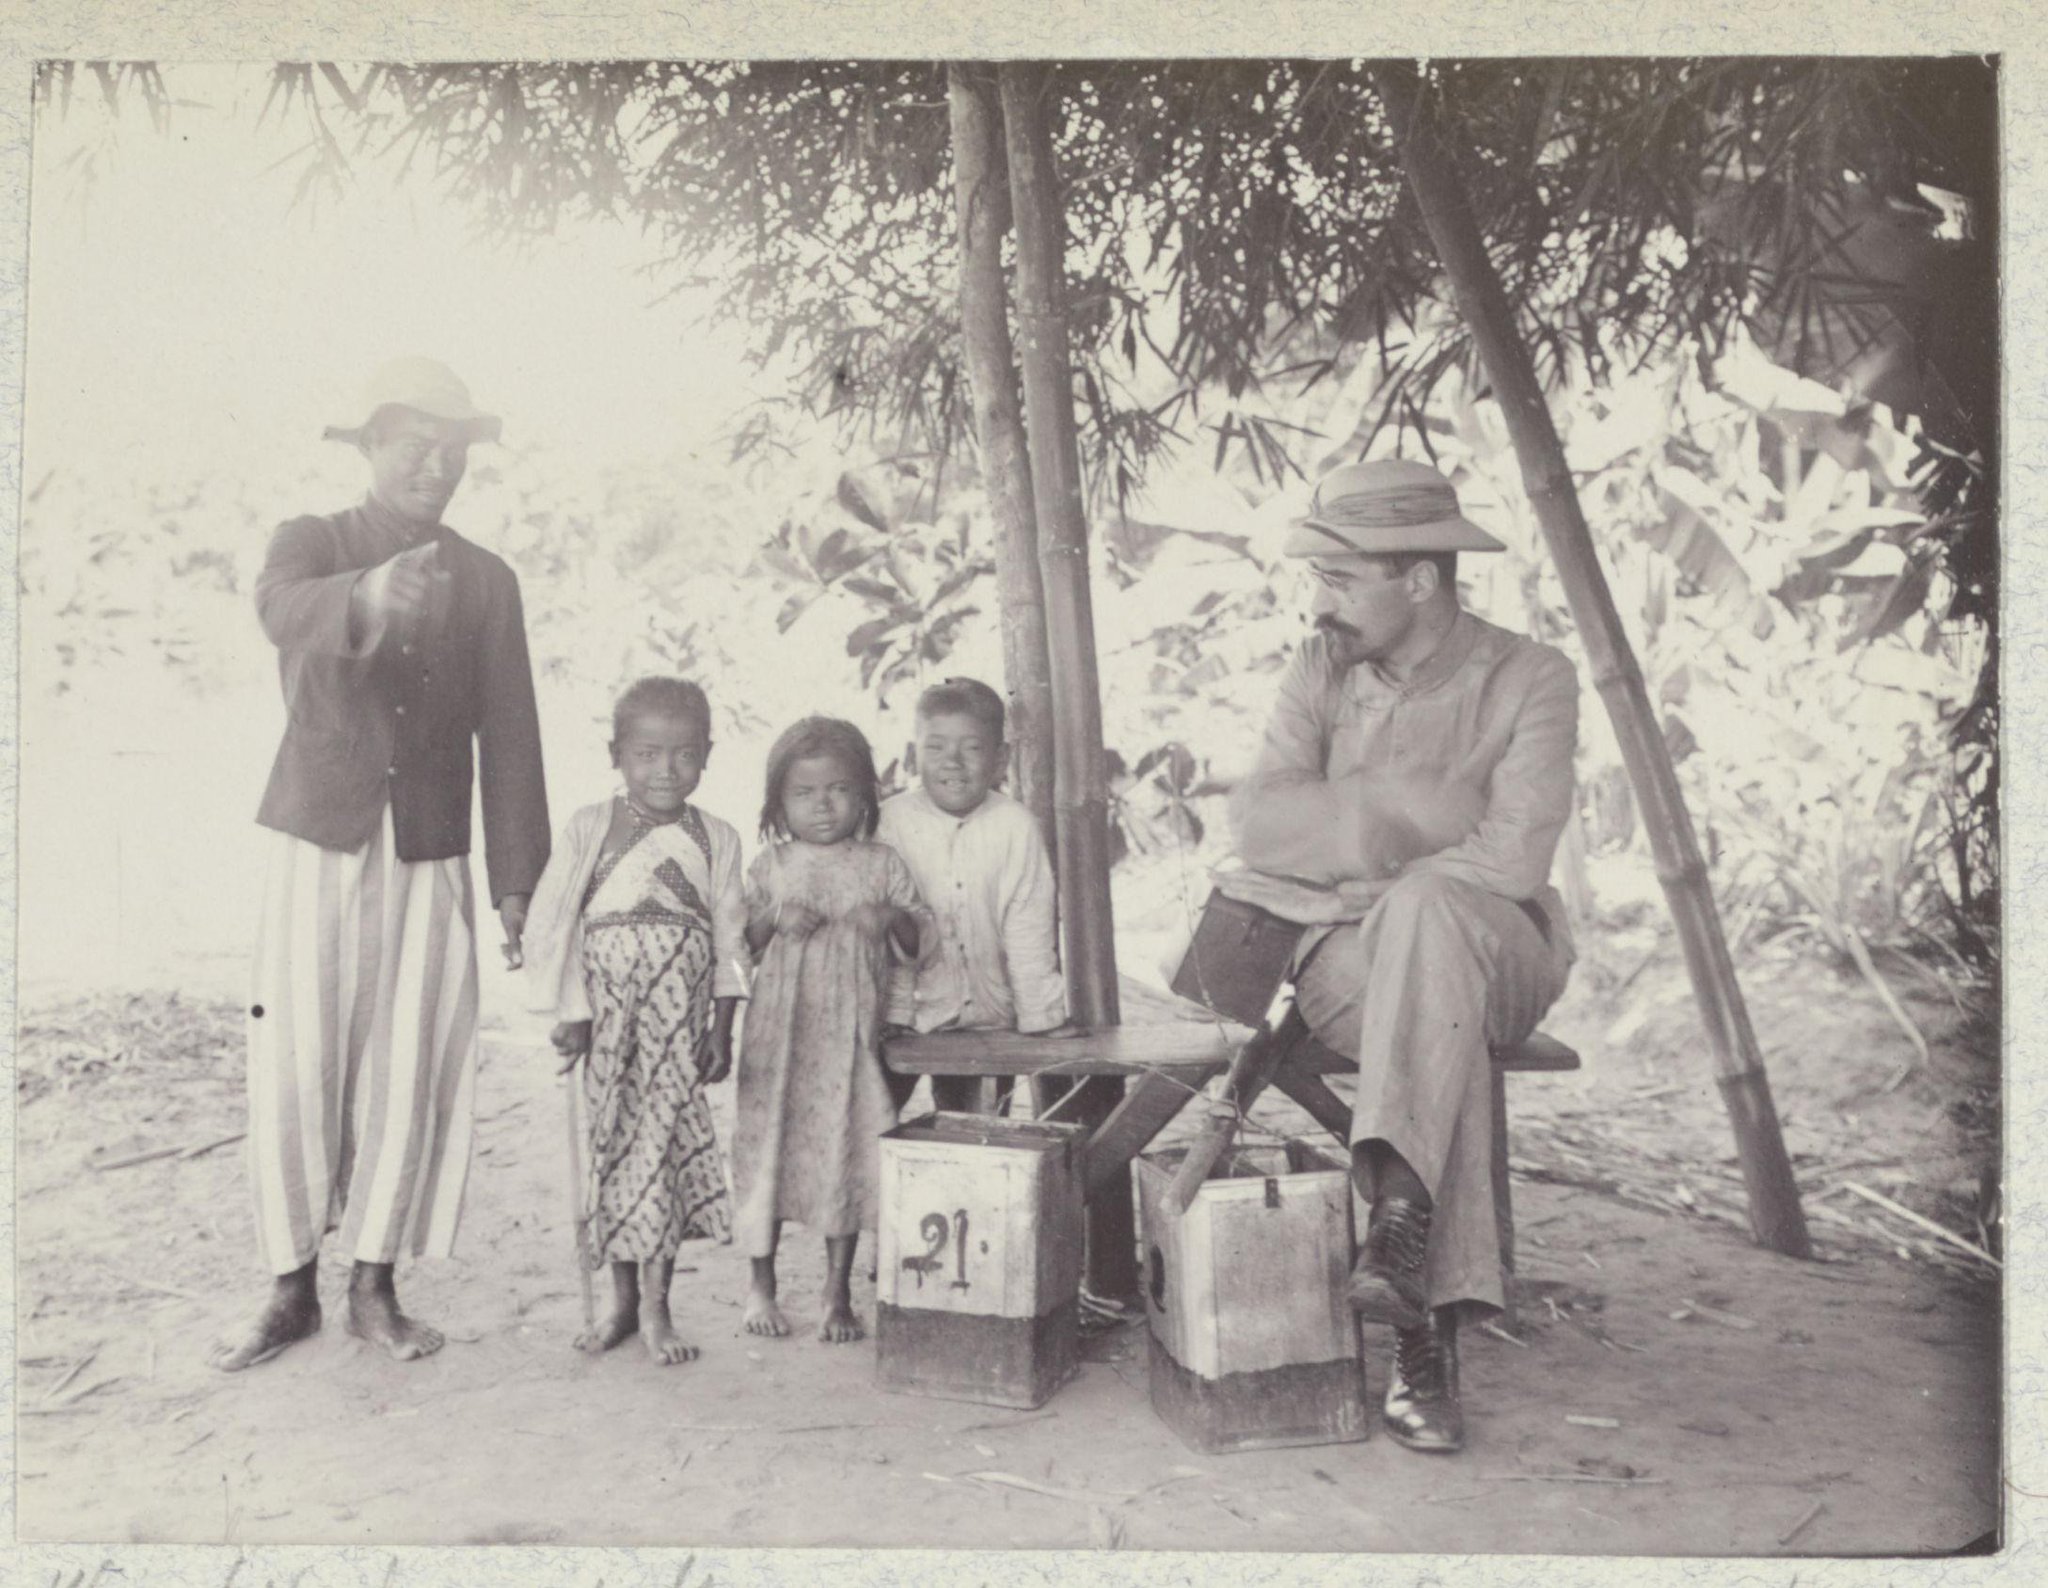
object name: photograph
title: Dhr. van de Werk in de Cultuurtuin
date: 1908-1910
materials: photographic support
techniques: photography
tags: botany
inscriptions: inscription: ‘V.d. Werk met Javaantjes in de Cultuurtuin P'bo October 1908’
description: Dhr. van de Werk met een Javaanse man en drie kinderen in de Cultuurtuin te Paramaribo, oktober 1908. Op de achtergrond bananenbomen. Onderdeel van het fotoalbum van de familie Boom-Gonggrijp in Suriname en Curaçao.